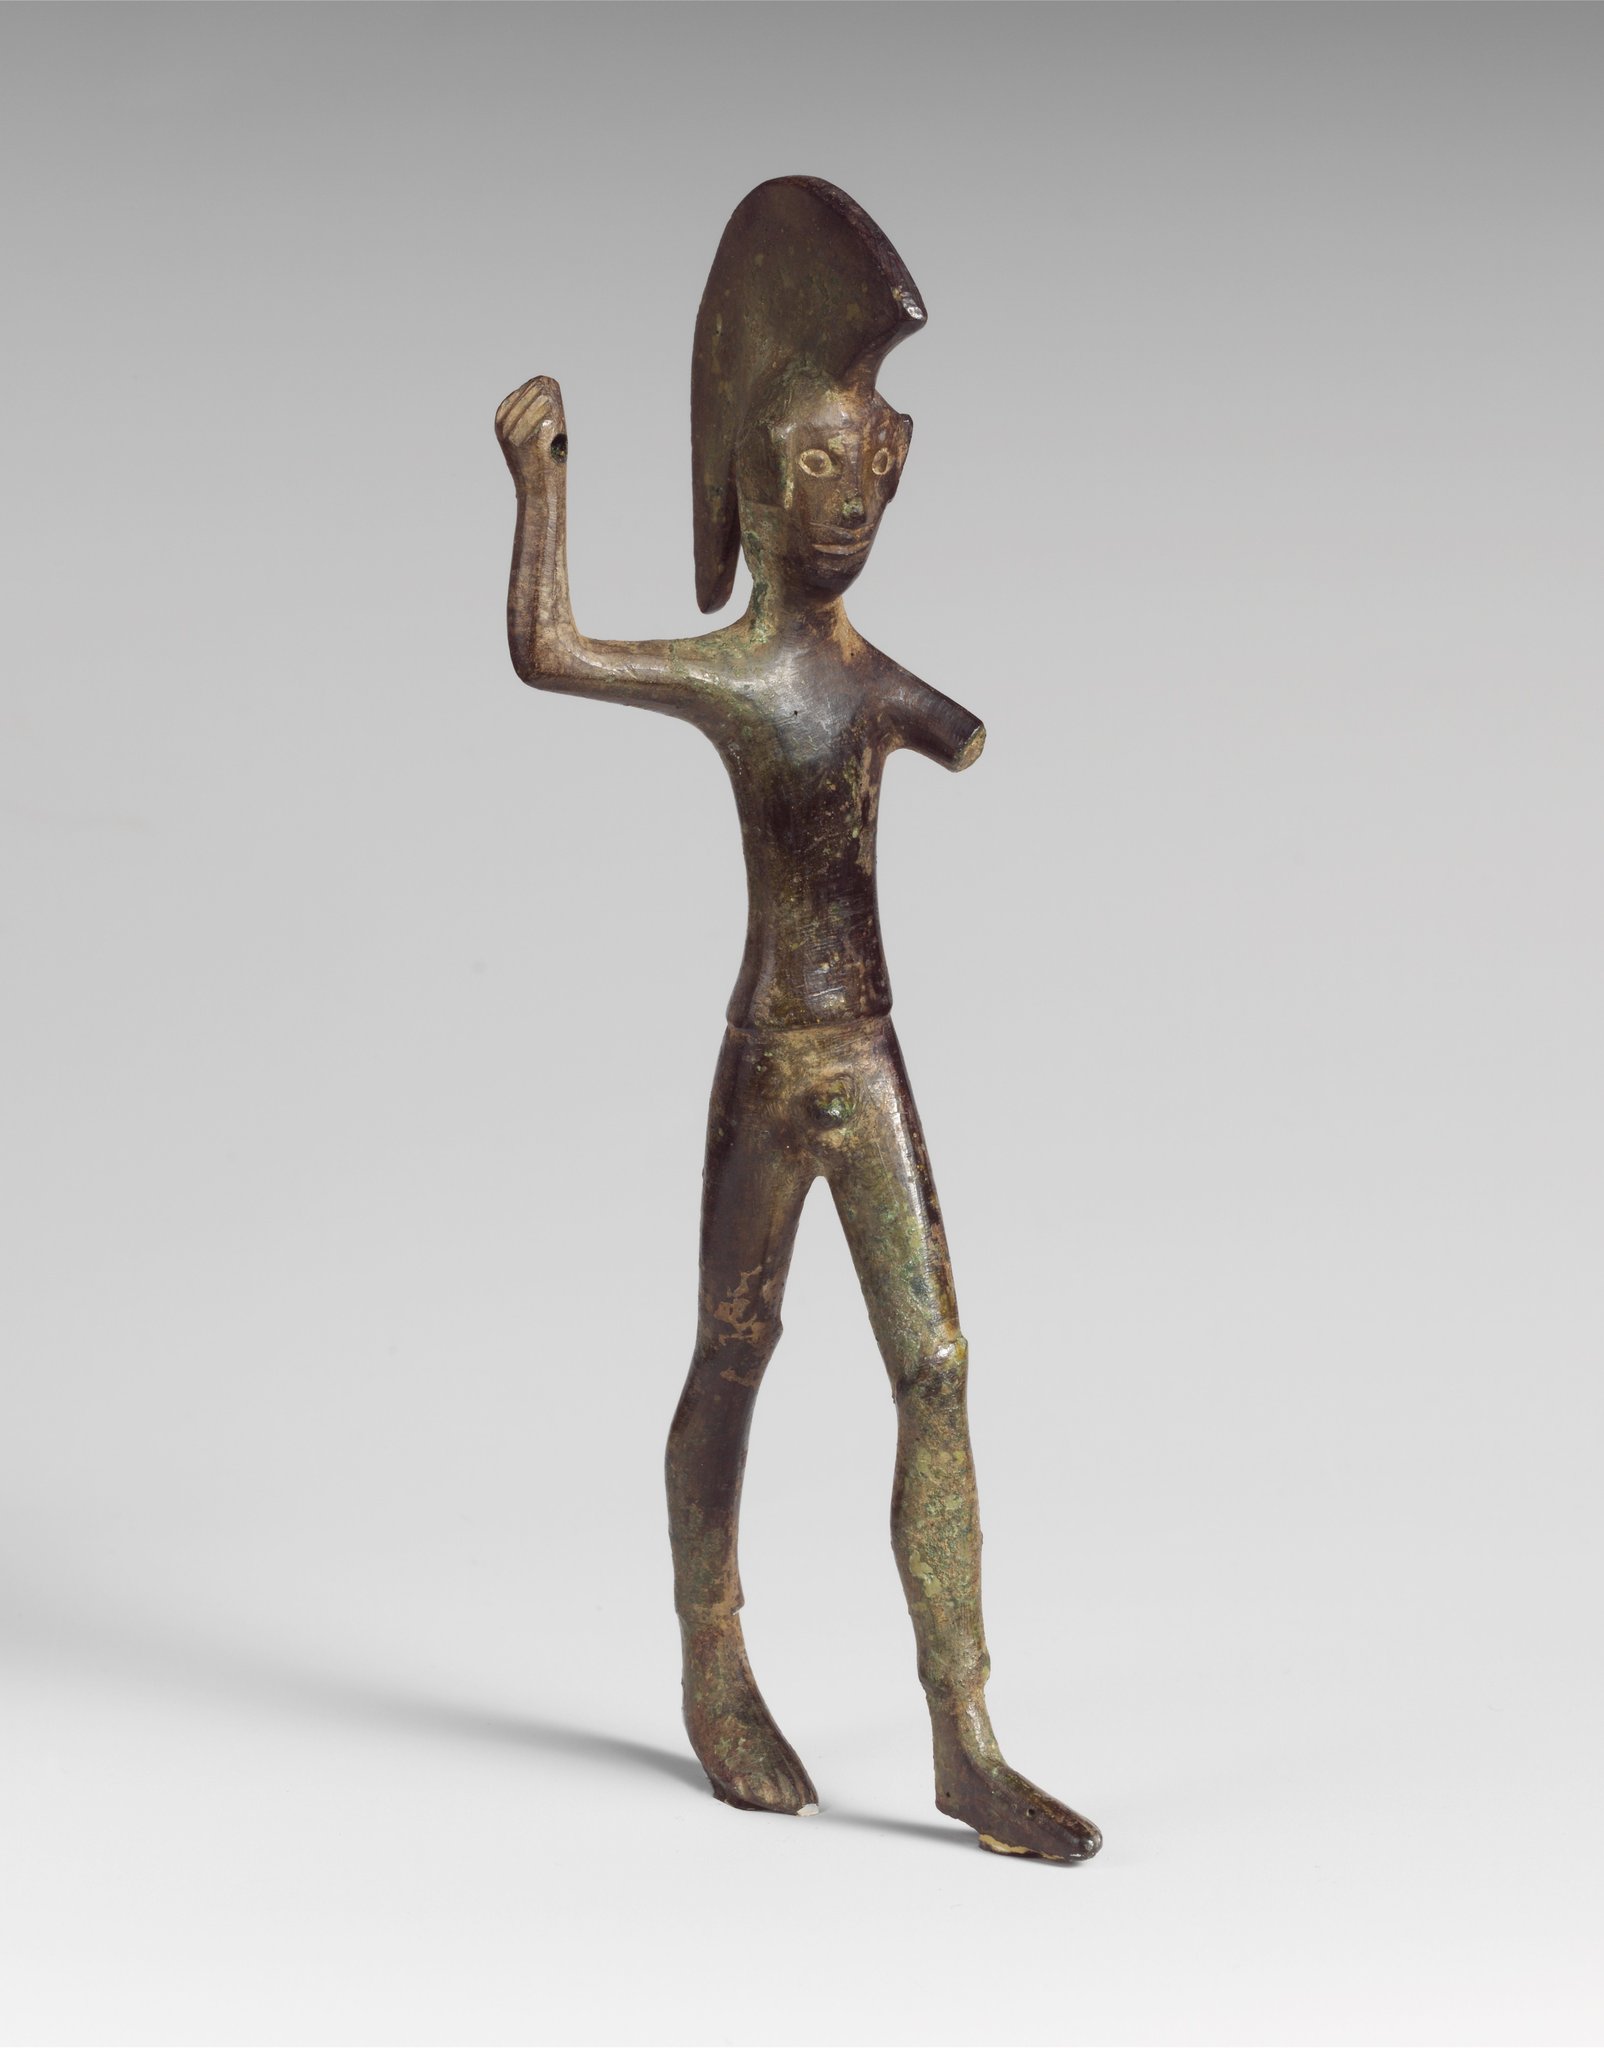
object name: statuette of a warrior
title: Bronze statuette of a striding warrior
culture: etruscan or umbrian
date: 600-401 BCE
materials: bronze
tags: helmets,men